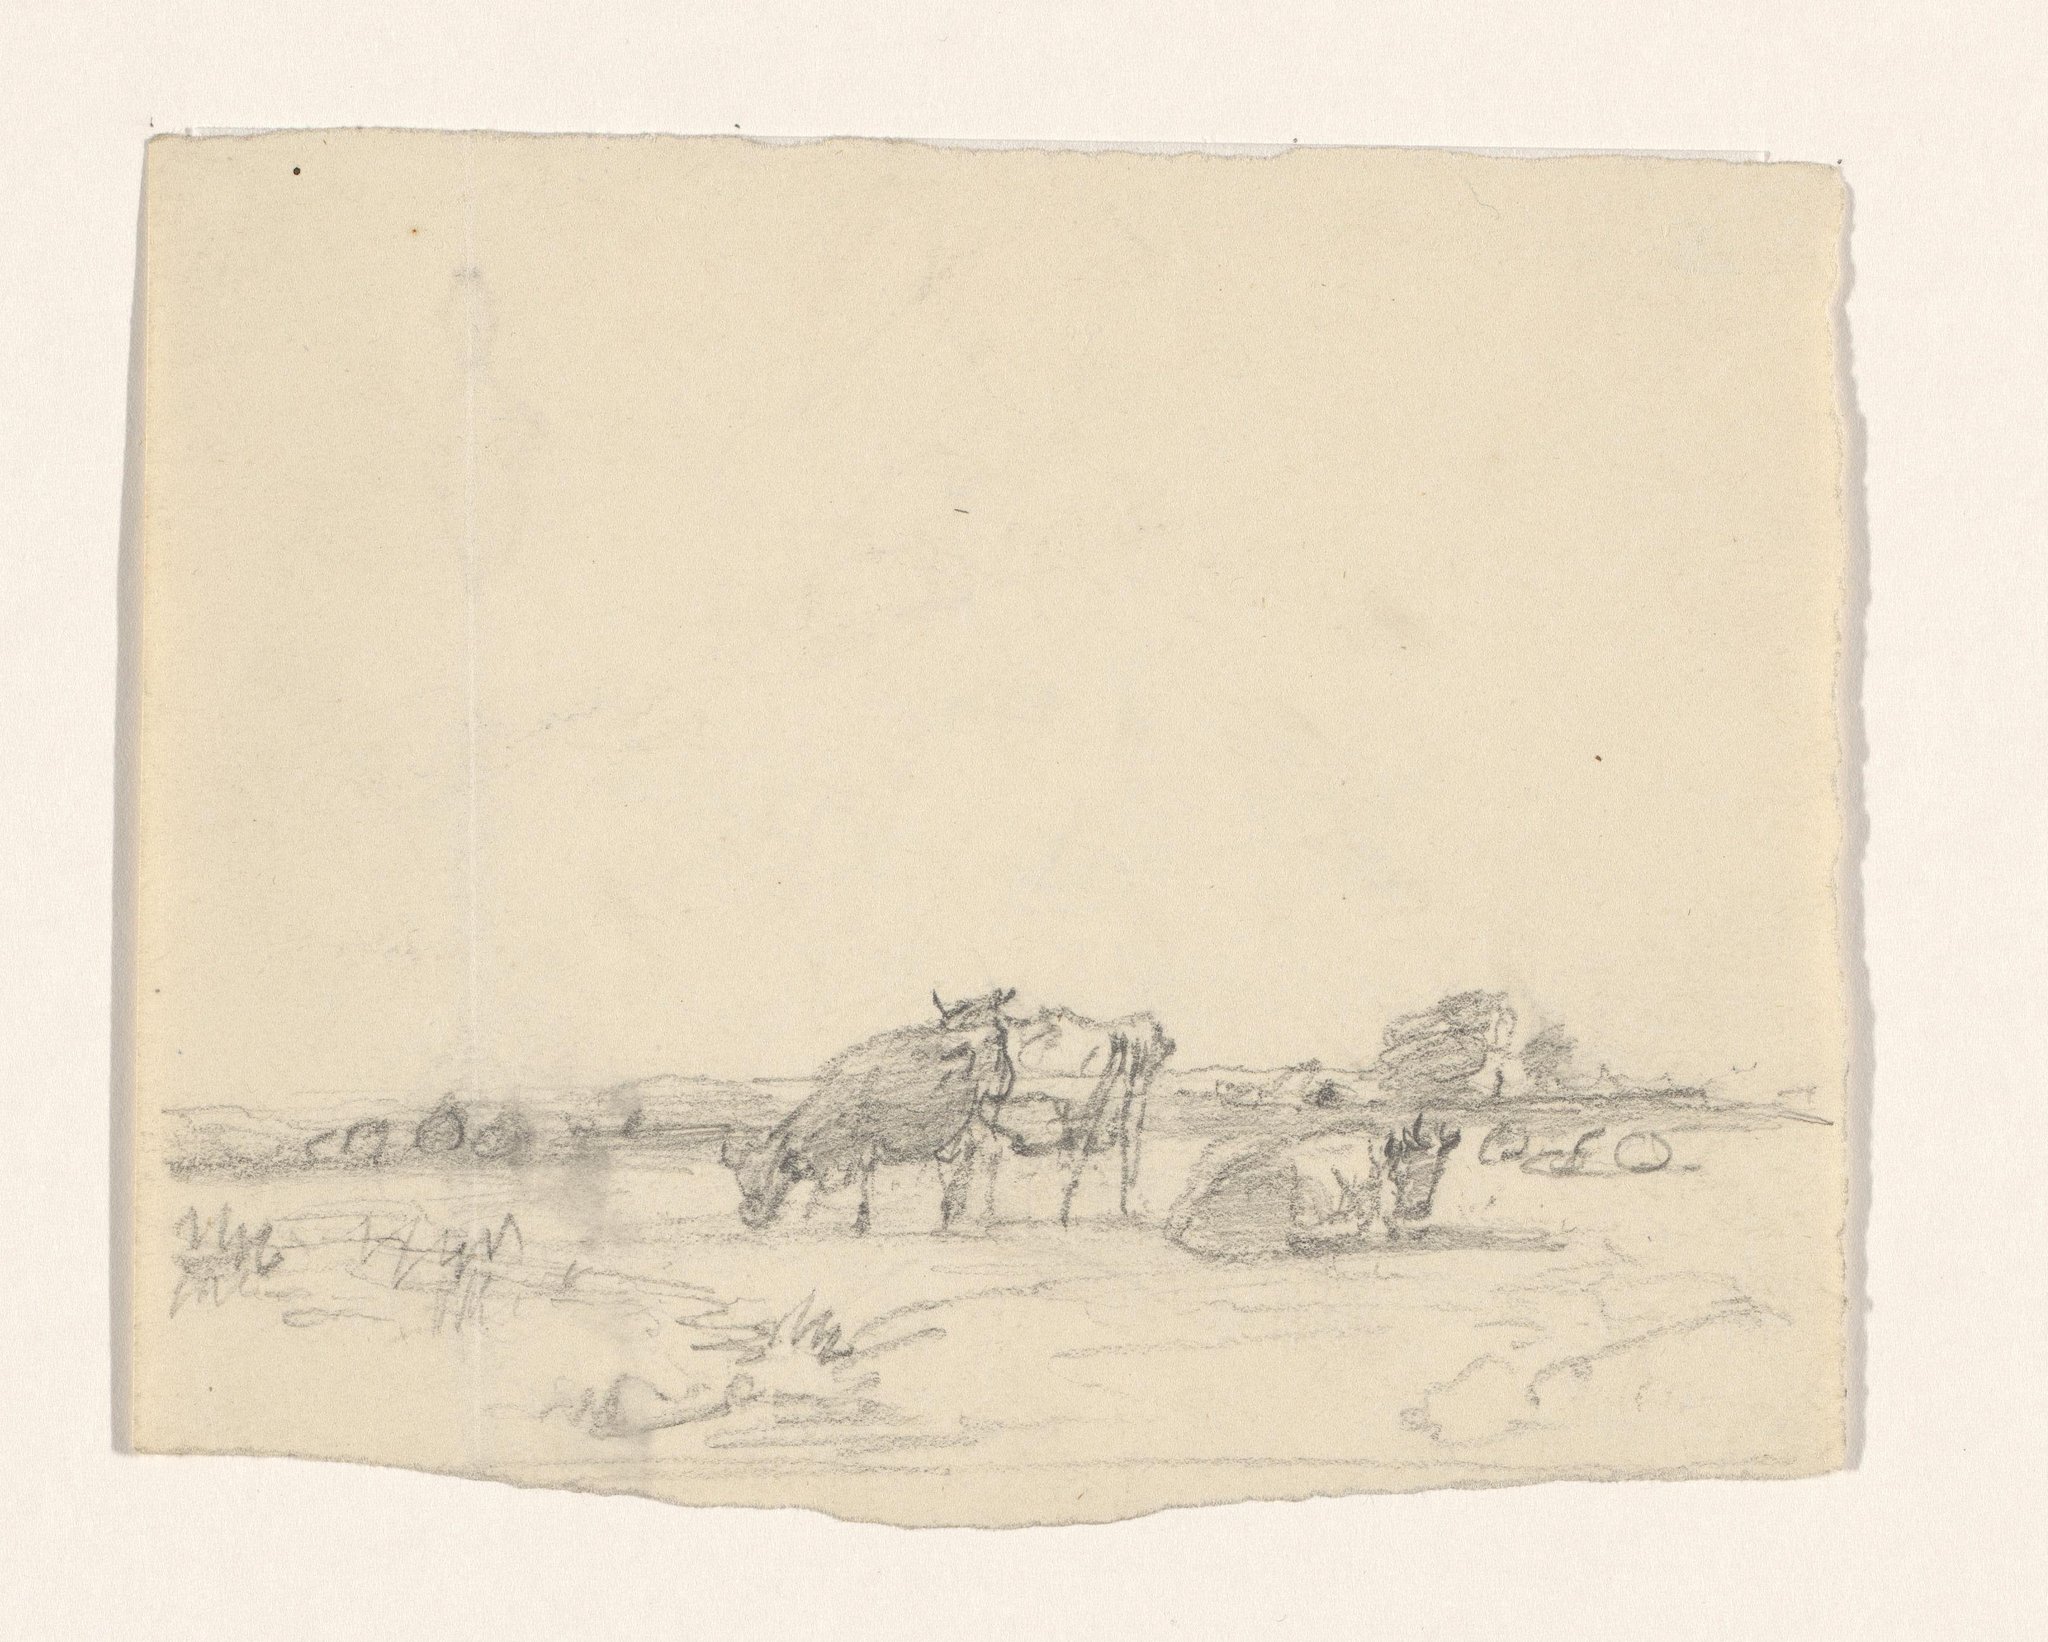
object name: drawing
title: Weidelandschap met grazende koeien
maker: jan bedijs tom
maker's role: draughtsman, painter, print maker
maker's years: 1813-1894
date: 1823-1894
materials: paper, pencil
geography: the hague